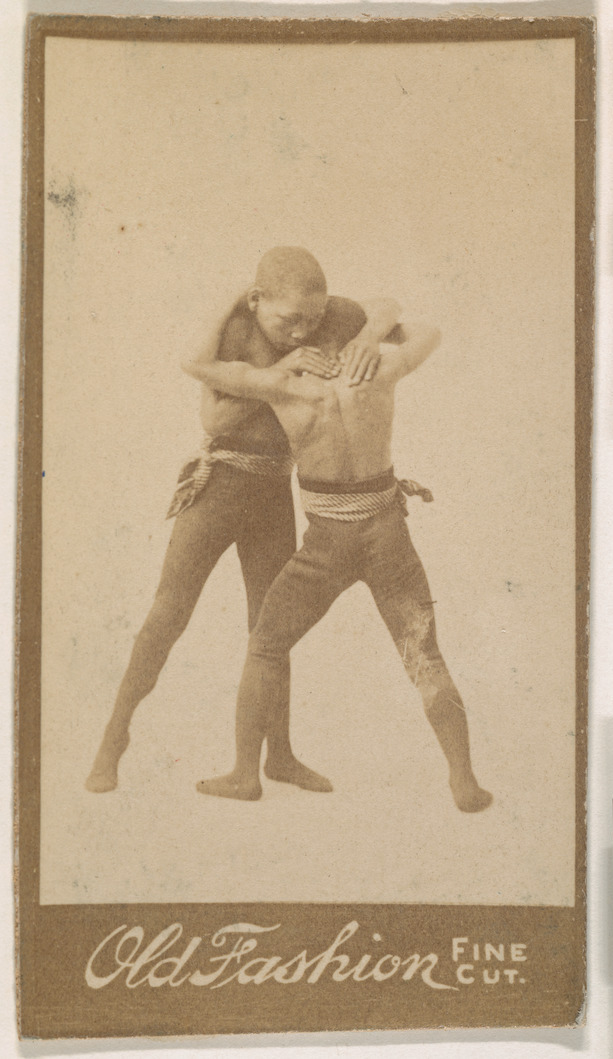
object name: photograph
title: Two boys wrestling, from the "Negro Subjects" series (N692) promoting Old Fashion Fine Cut Tobacco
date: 1888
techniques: albumen silver print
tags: boys,athletes,wrestling